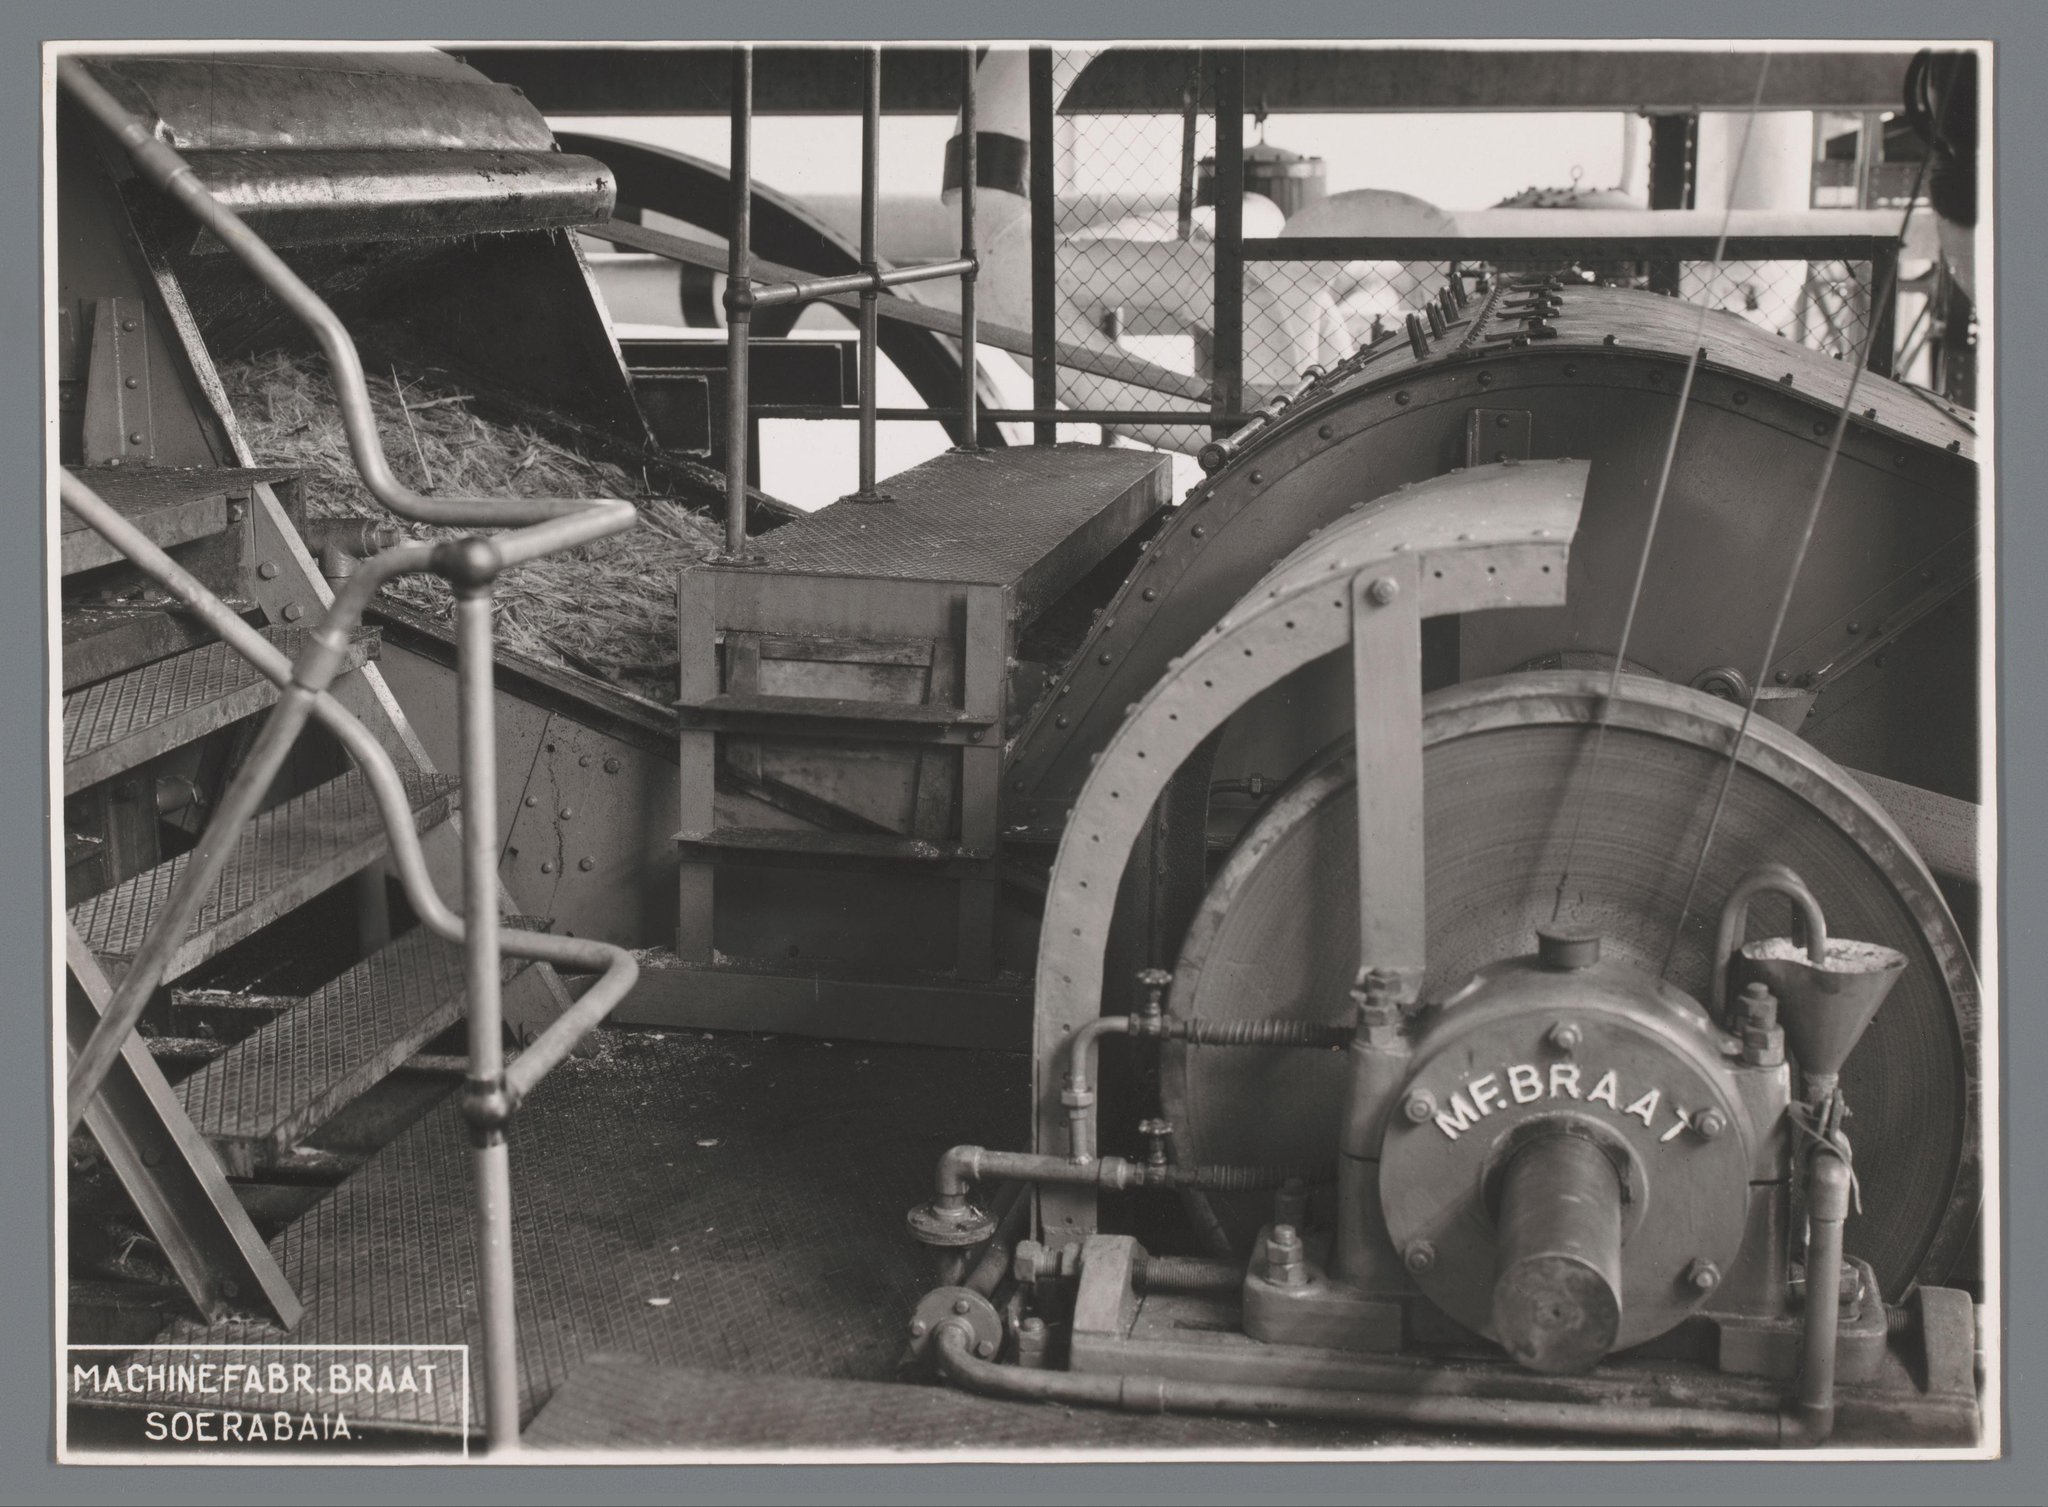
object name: photograph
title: Canecutter in bedrijf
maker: Anonymous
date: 1911-1938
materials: photographic support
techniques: gelatin silver print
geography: java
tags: colonial system, machines; parts of machines; tools and appliances, (non-fruit) products of plants or trees: sugarcane, interior of industrial structures (regardless of the materials processed or the products made, java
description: Canecutter in bedrijf op de Suikerfabriek Pesantren bij Kediri. Onderdeel van de multomap met foto's van machines van de N.V. Machinefabriek Braat te Soerabaja bestemd voor de Nederlandse suikerindustrie op Java, uit de periode 1917-1938.